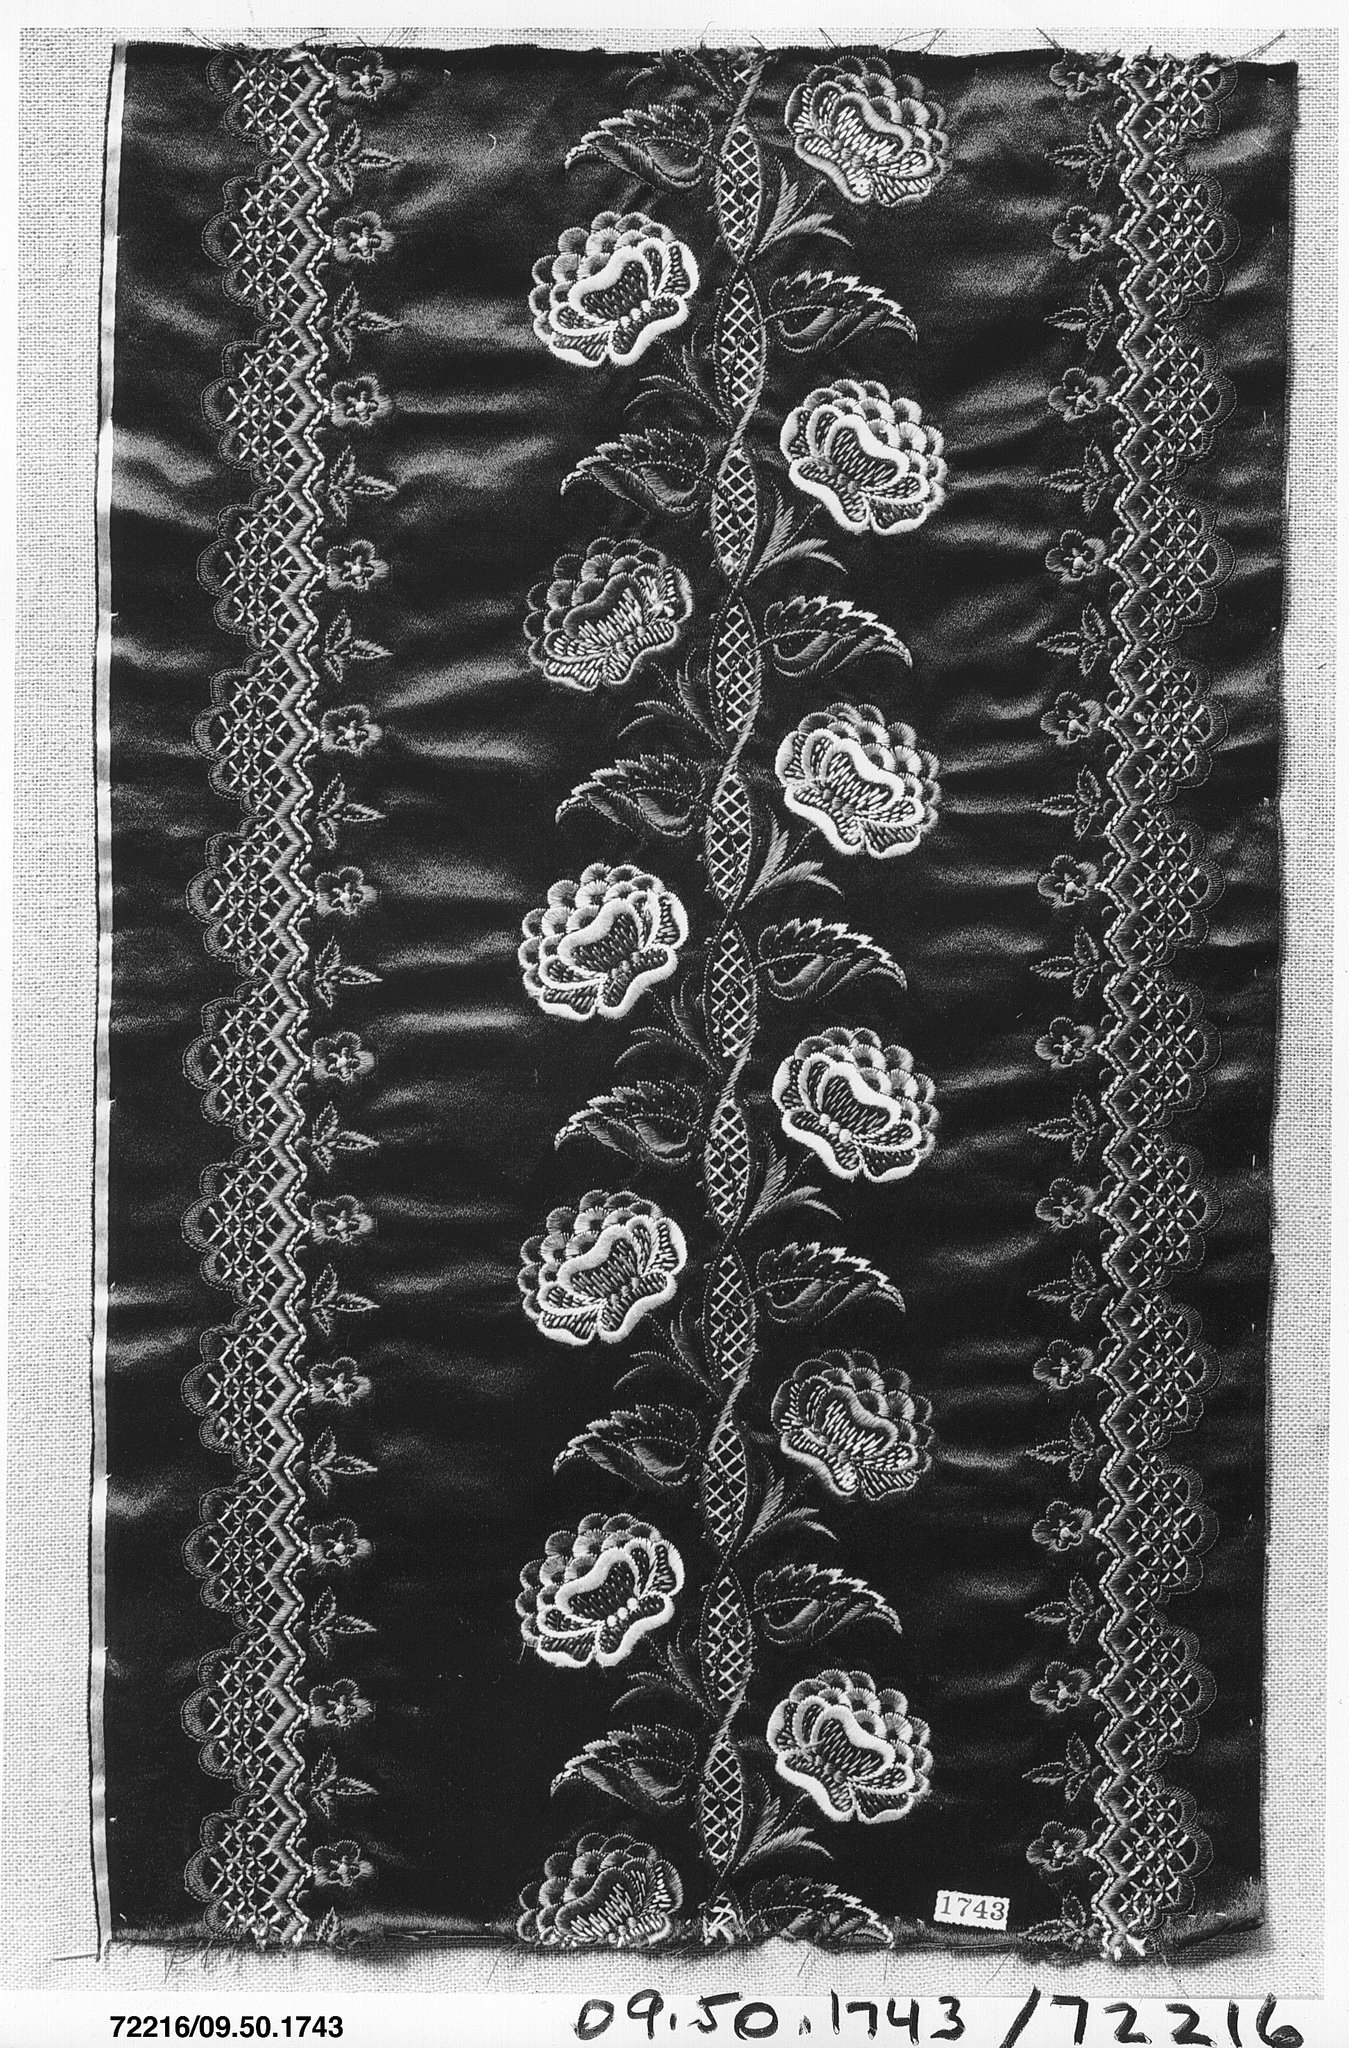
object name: fragment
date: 1801-1900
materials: silk